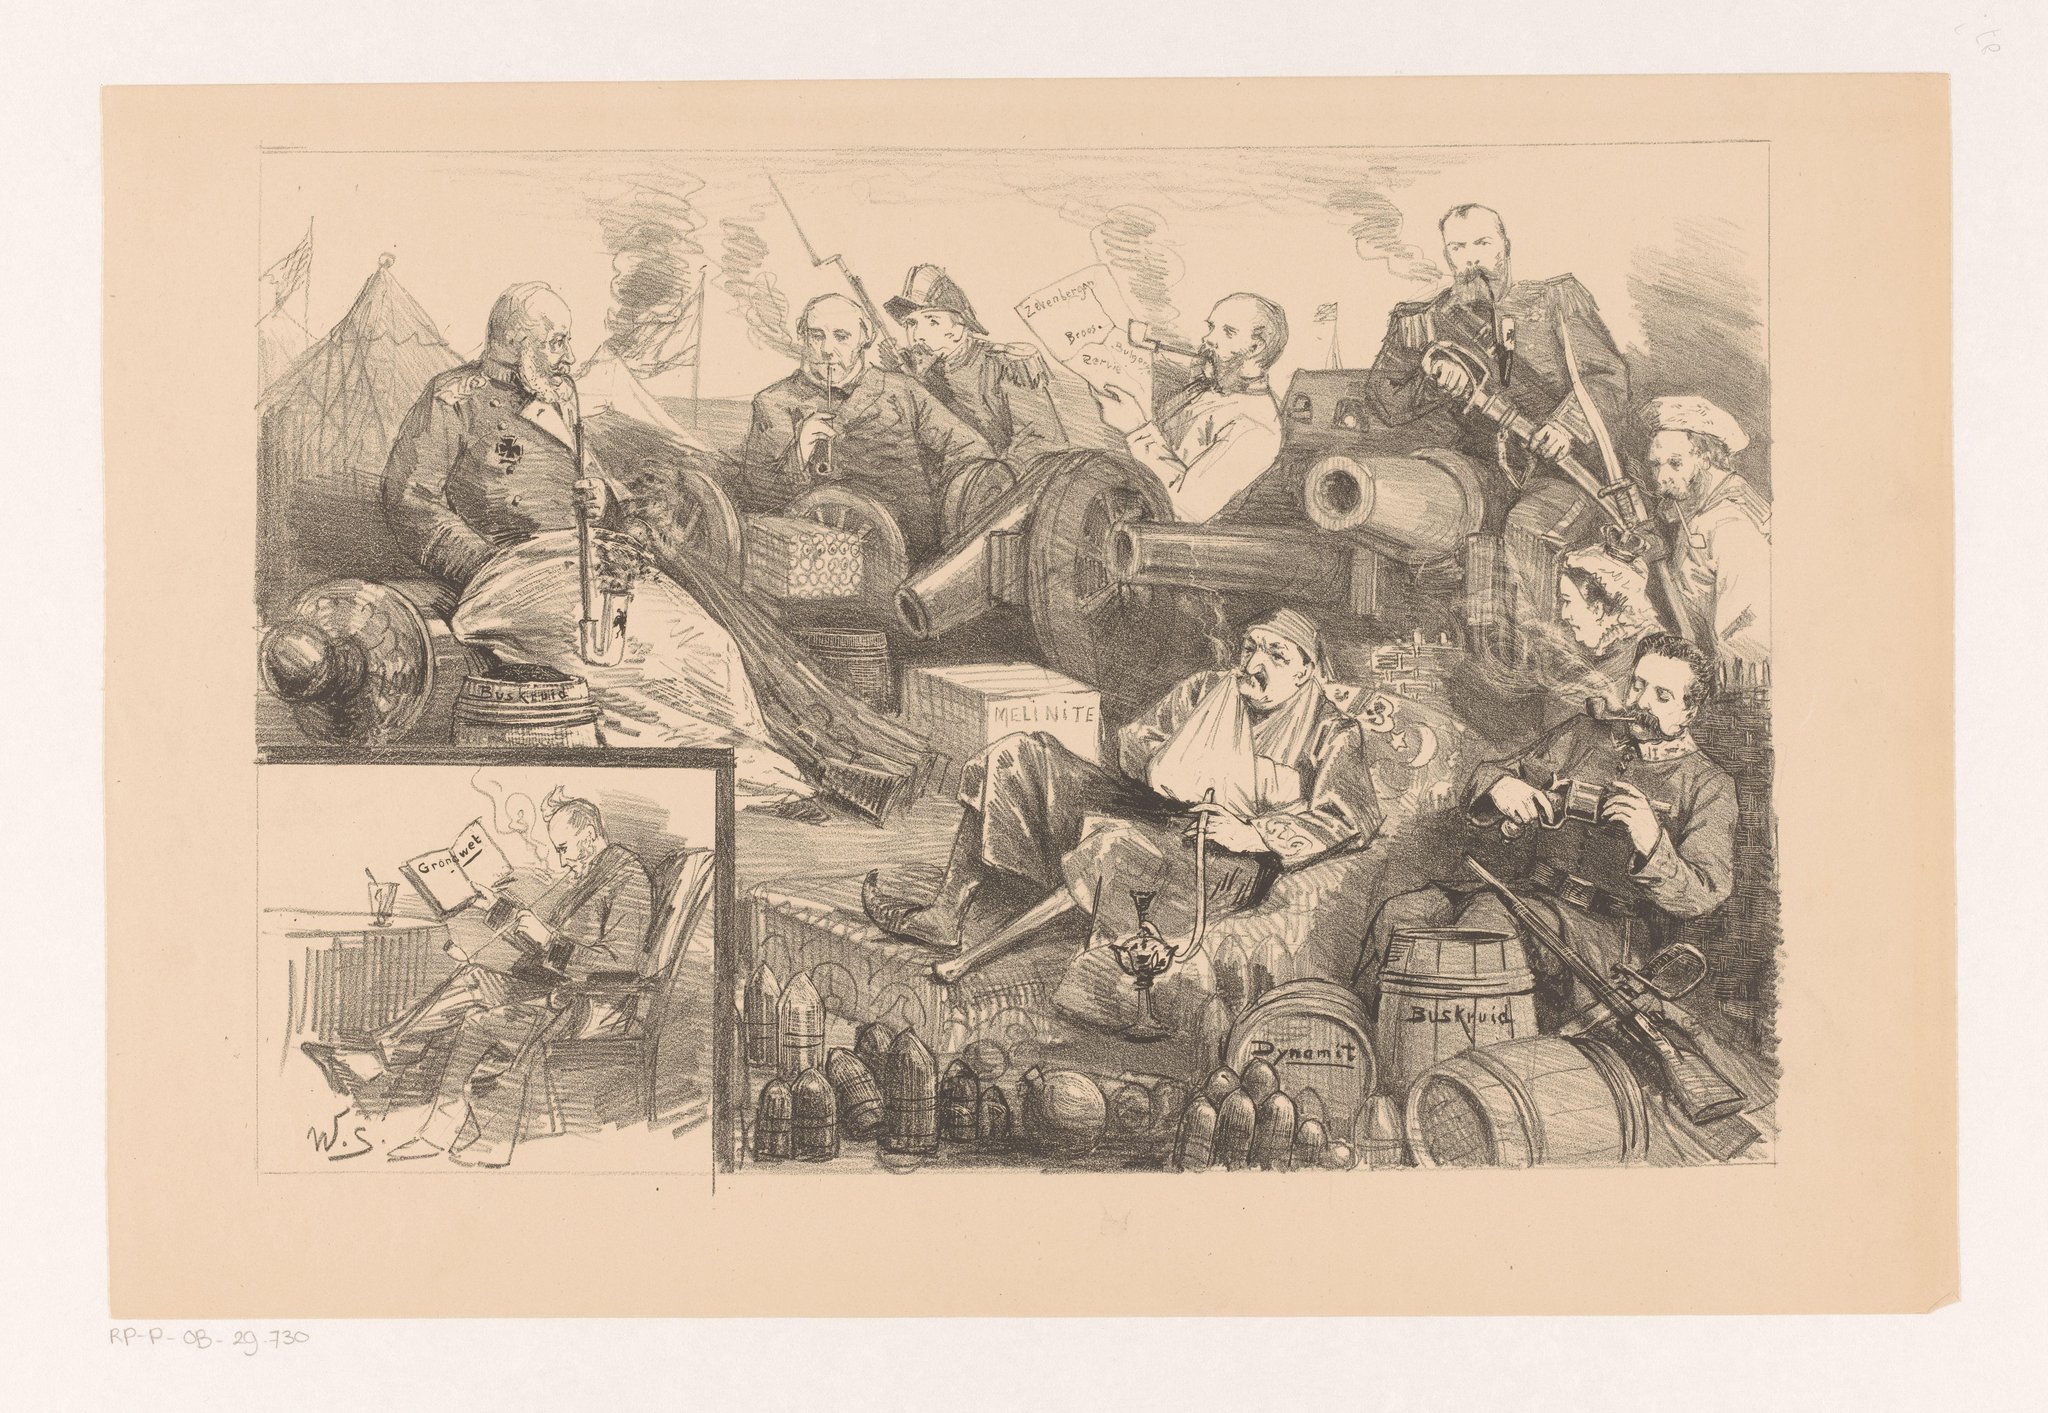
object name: cartoon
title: Spotprent met pijprokende mannen tussen buskruit en dynamiet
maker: willem steelink (ii)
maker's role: draughtsman, print maker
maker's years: 1856-1928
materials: paper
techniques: lithograph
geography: netherlands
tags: pipe ~ tobacco, weapons, projectiles, explosives, etc.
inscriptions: collector's mark: Lugt 2228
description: Een groep mannen en een koningin (mogelijk Emma) te midden van vaten buskruit, dynamiet, meliniet, kanonnen en kogels. Links onder zit de pijprokende Jan Heemskerk Azn. met de vernieuwde grondwet.